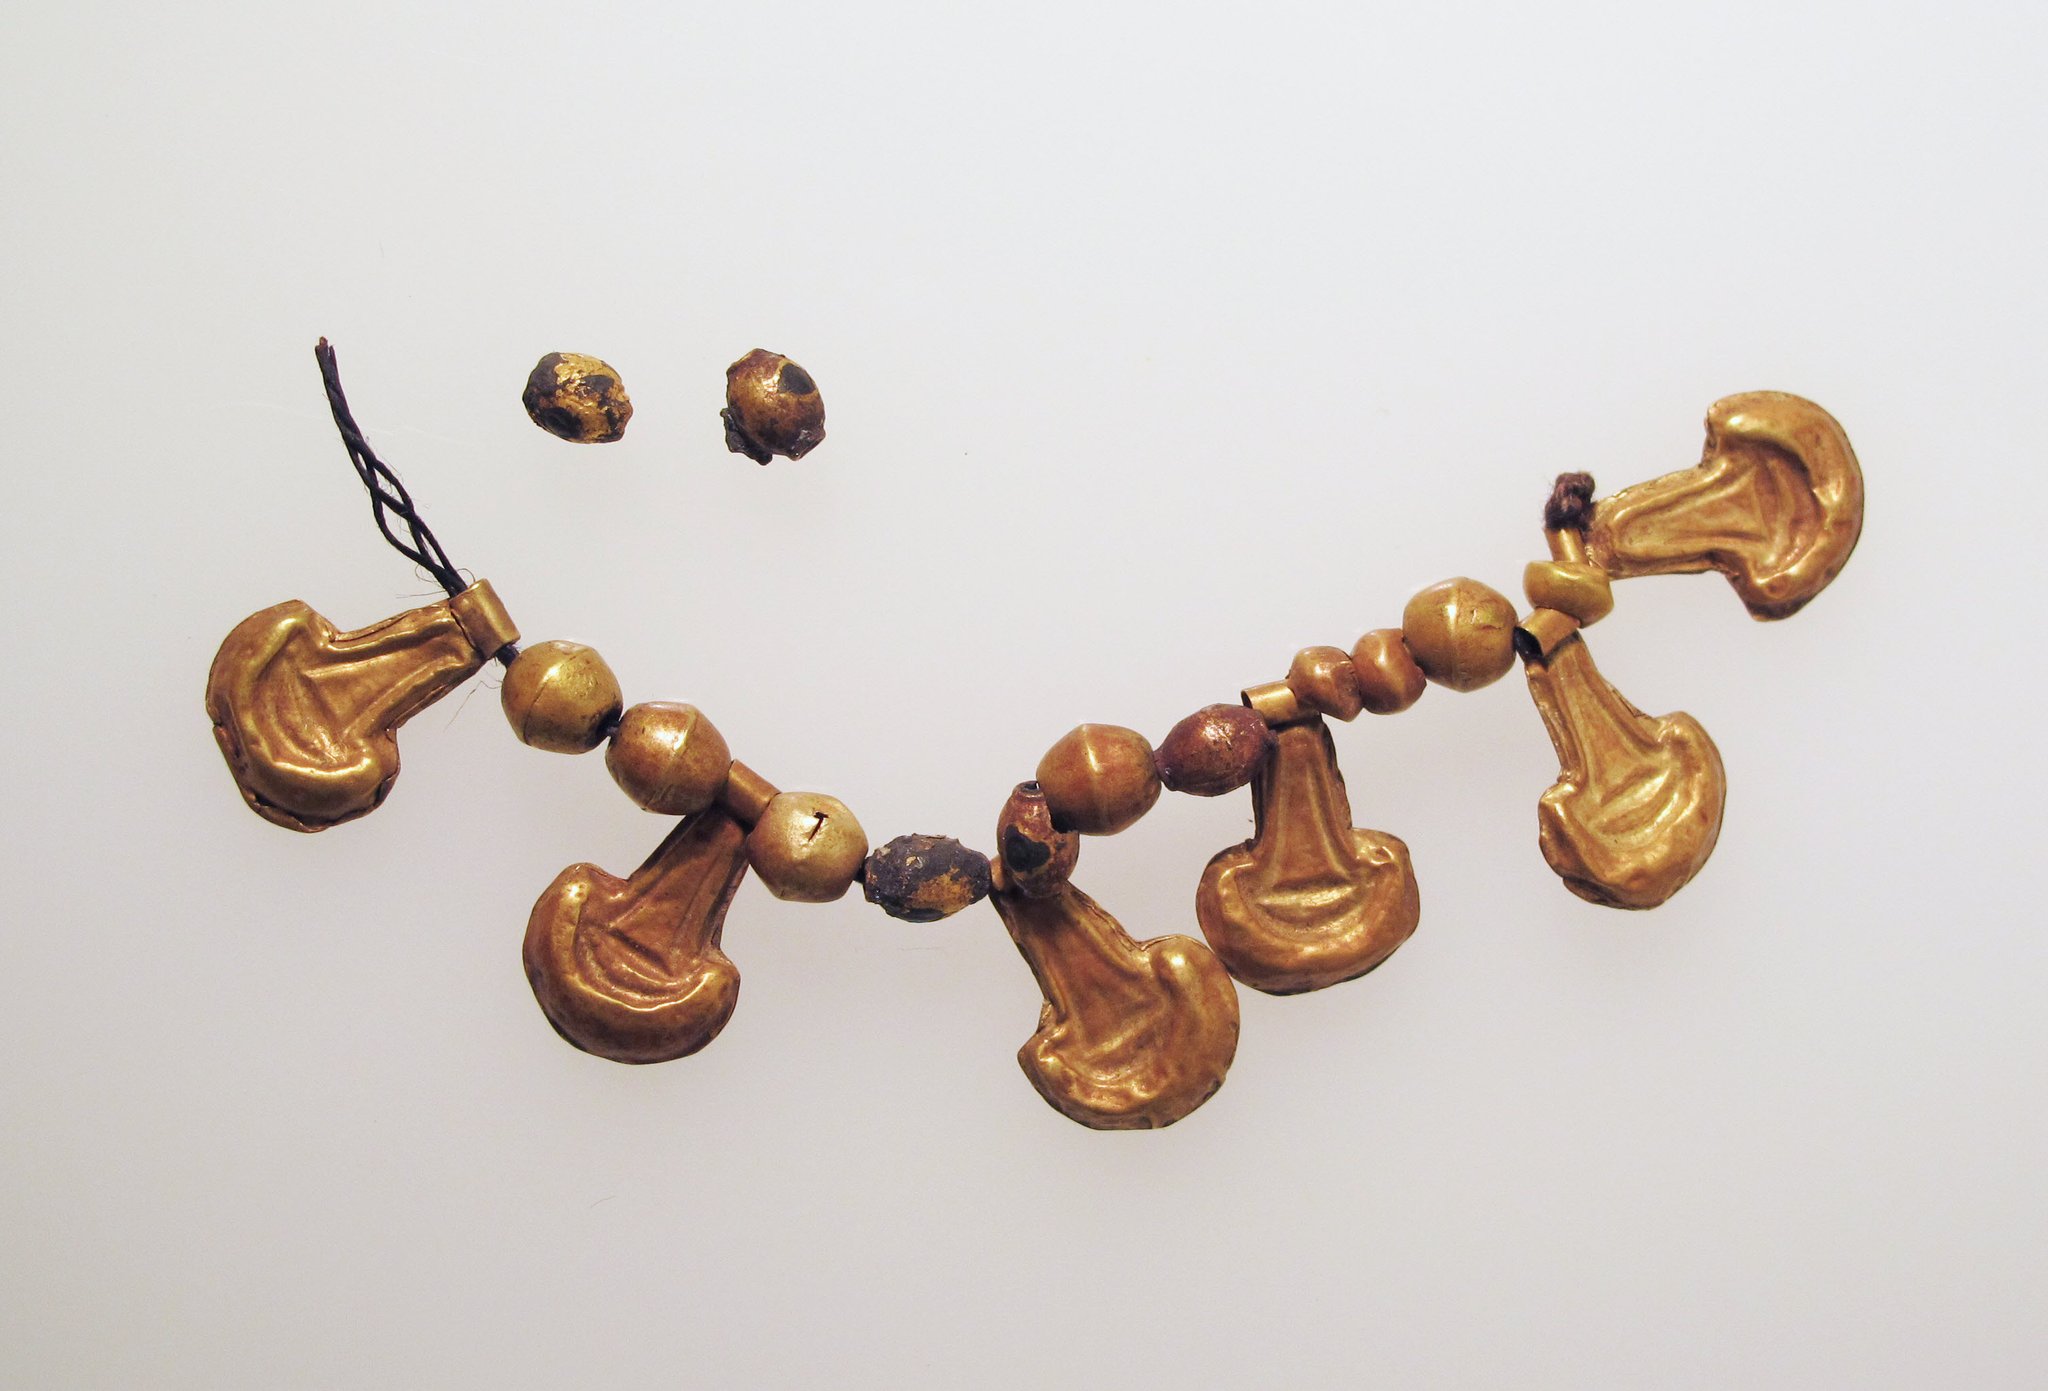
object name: bead pendant, with lotus flower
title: Bead pendant, with lotus flowers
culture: cypriot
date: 3900 BCE-100 CE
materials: gold